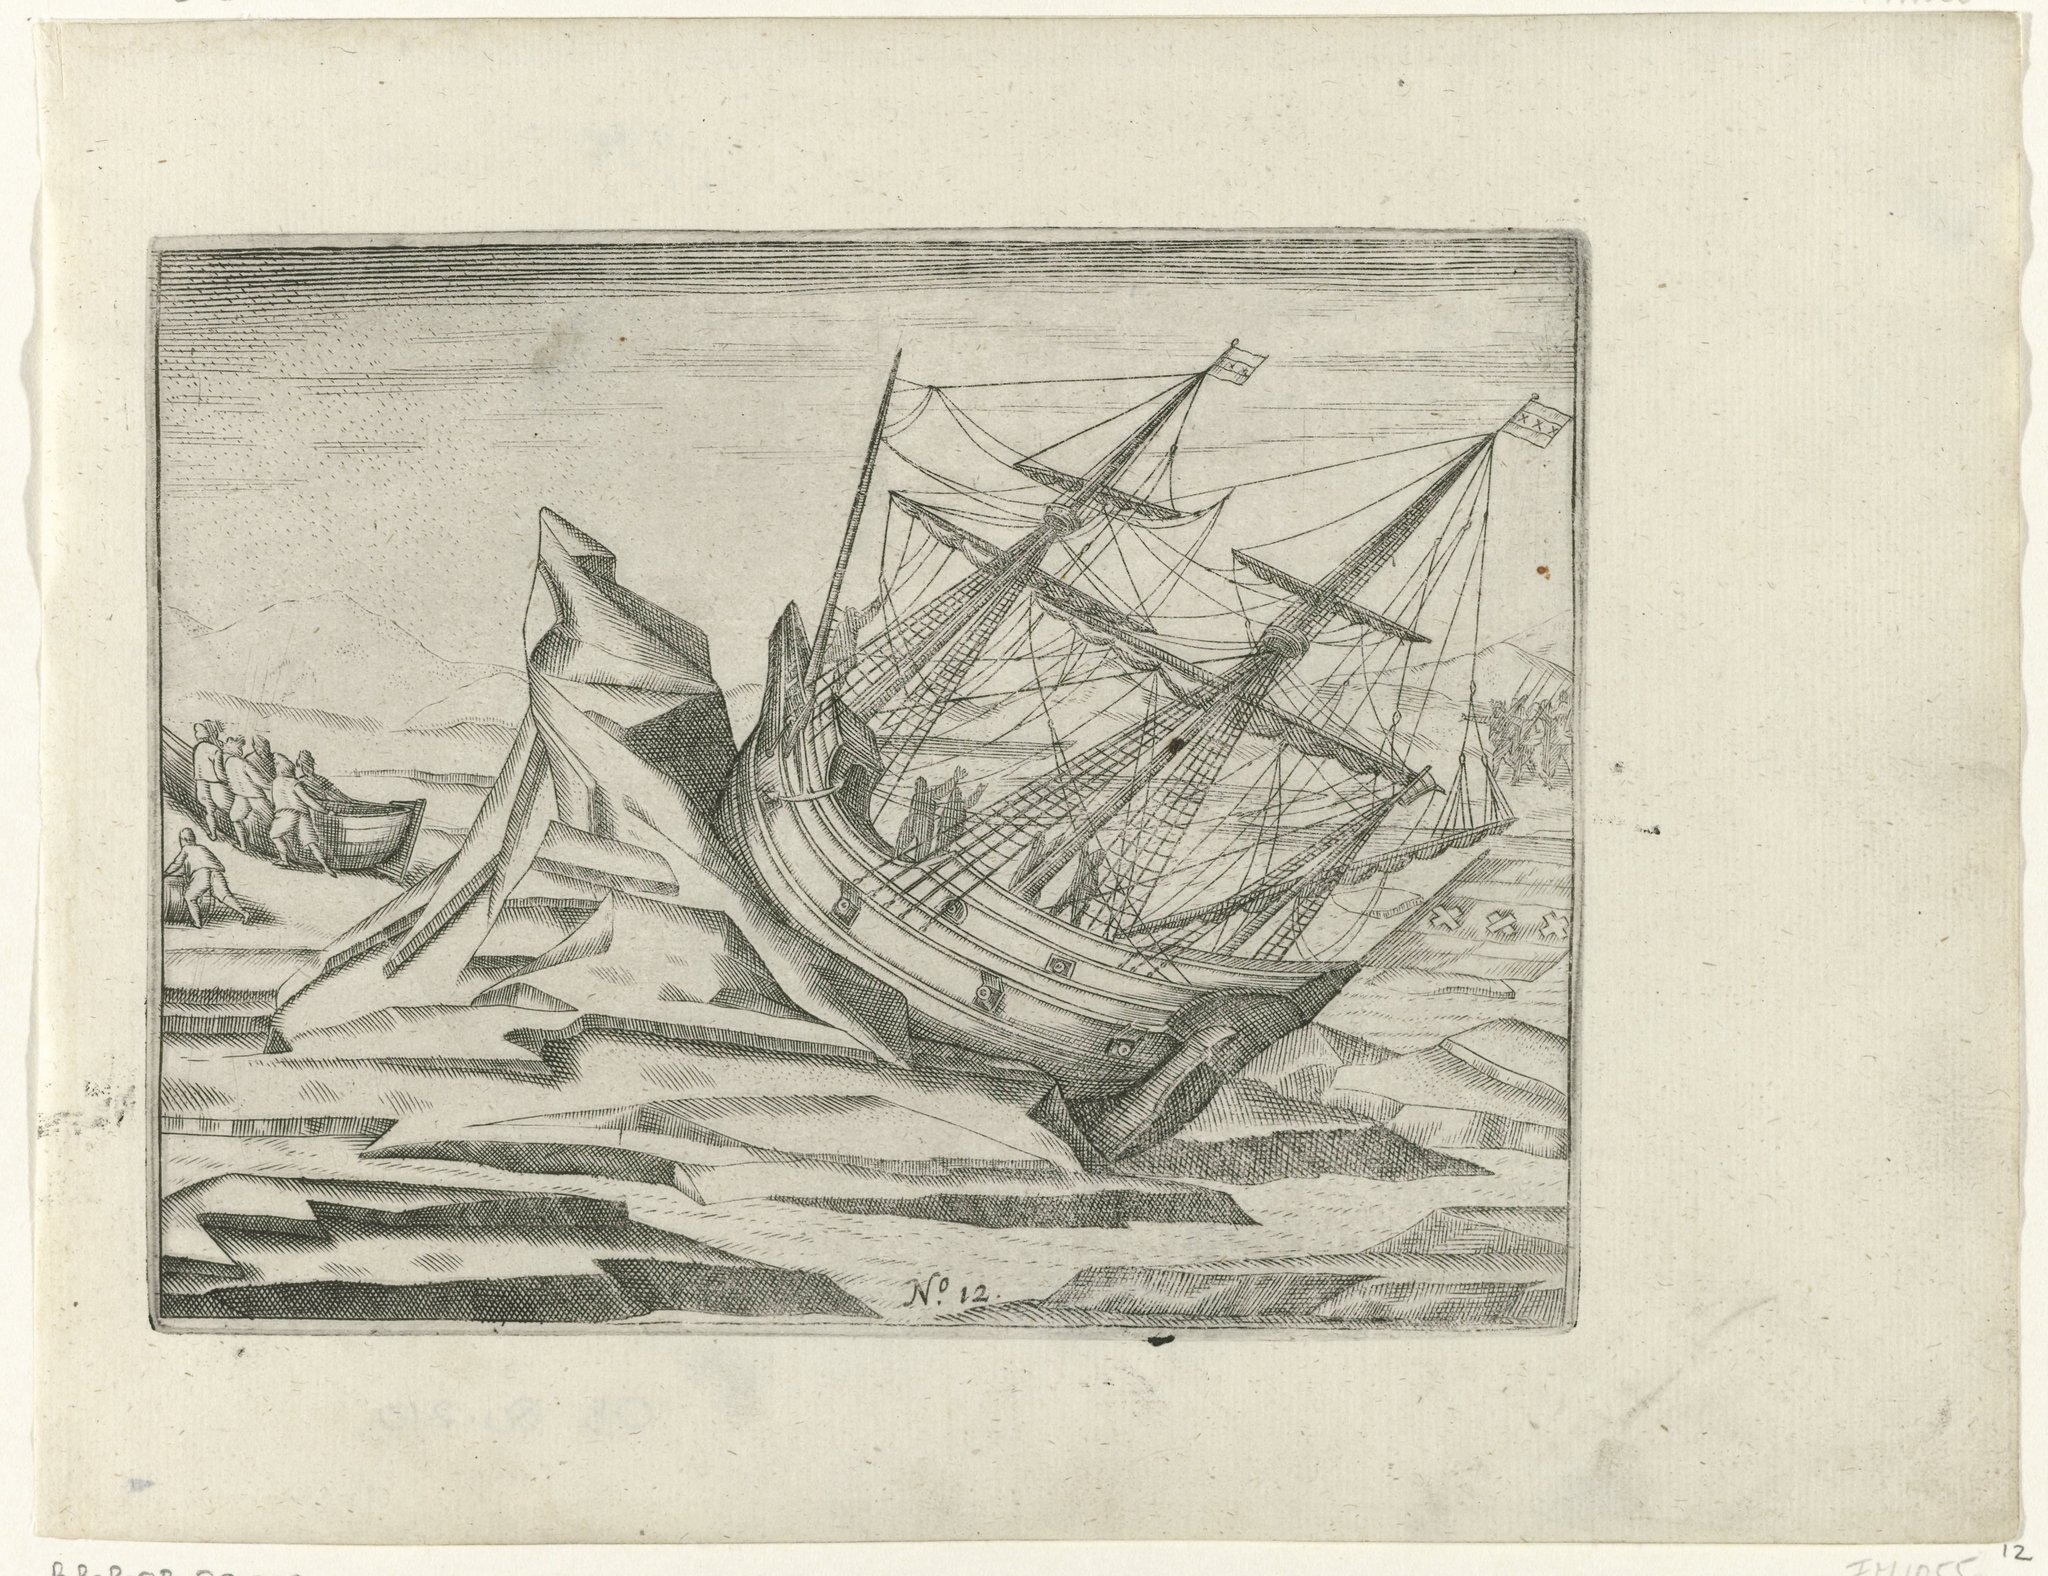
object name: history print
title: Het schip vastgelopen in het ijs, 1596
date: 1615-1617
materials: paper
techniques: engraving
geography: northern netherlands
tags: willem barendsz., amsterdam, jacob van heemskerck, shipwreck, landscapes in polar regions, exploration, expedition, voyage of discovery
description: Gebruikt als illustratie eerst in: G. de Veer, De waerachtige beschrijvinge vande drie seylagien, drie jaren achter mal-kanderen deur de Hollandtsche ende Zeelandtsche Schepen, by noorden Noorweghen, Moscovien ende tartarien nae de Coninckrijcken van Catthay ende China ghedaene, [Michiel Colijn, Amsterdam 1617]. Later gebruikt in: Kort verhael van d'eerste Schipvaerd der Hollandsche ende Zeeusche Schepen by noorden Noorwegen, Moscovien ende Tartarien om, nae de Coningrijcken van Cathay ende China, getogen uyt het Journael van Gerrit de Veer. Opgenomen in: I. Commelin, Begin ende voortgangh, van de Vereenighde Nederlantsche Geoctroyeerde Oost-Indische Compagnie, J. Janssonius, Amsterdam 1646. Genummerd: No. 12.